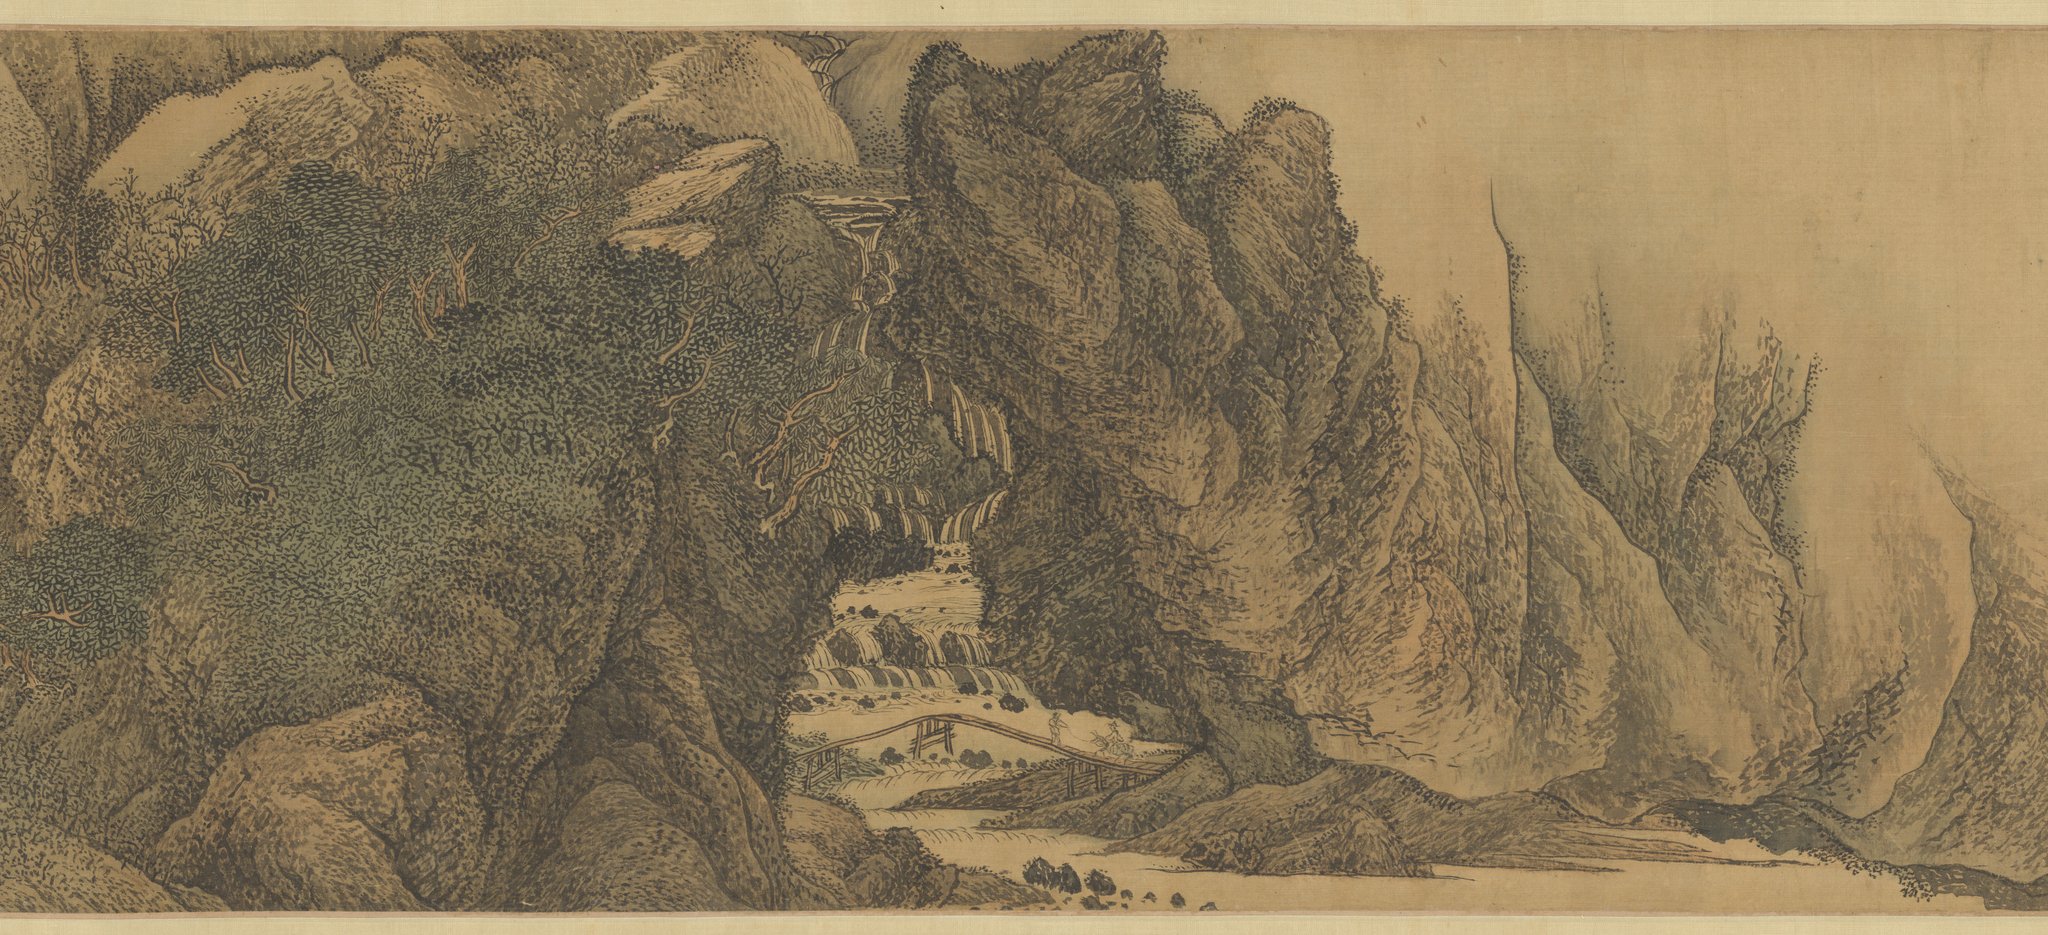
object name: handscroll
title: The Colors of Mount Taihang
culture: chinese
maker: wang hui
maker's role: artist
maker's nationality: chinese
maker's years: 1632-1717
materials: ink, silk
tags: waterfalls,mountains,landscapes